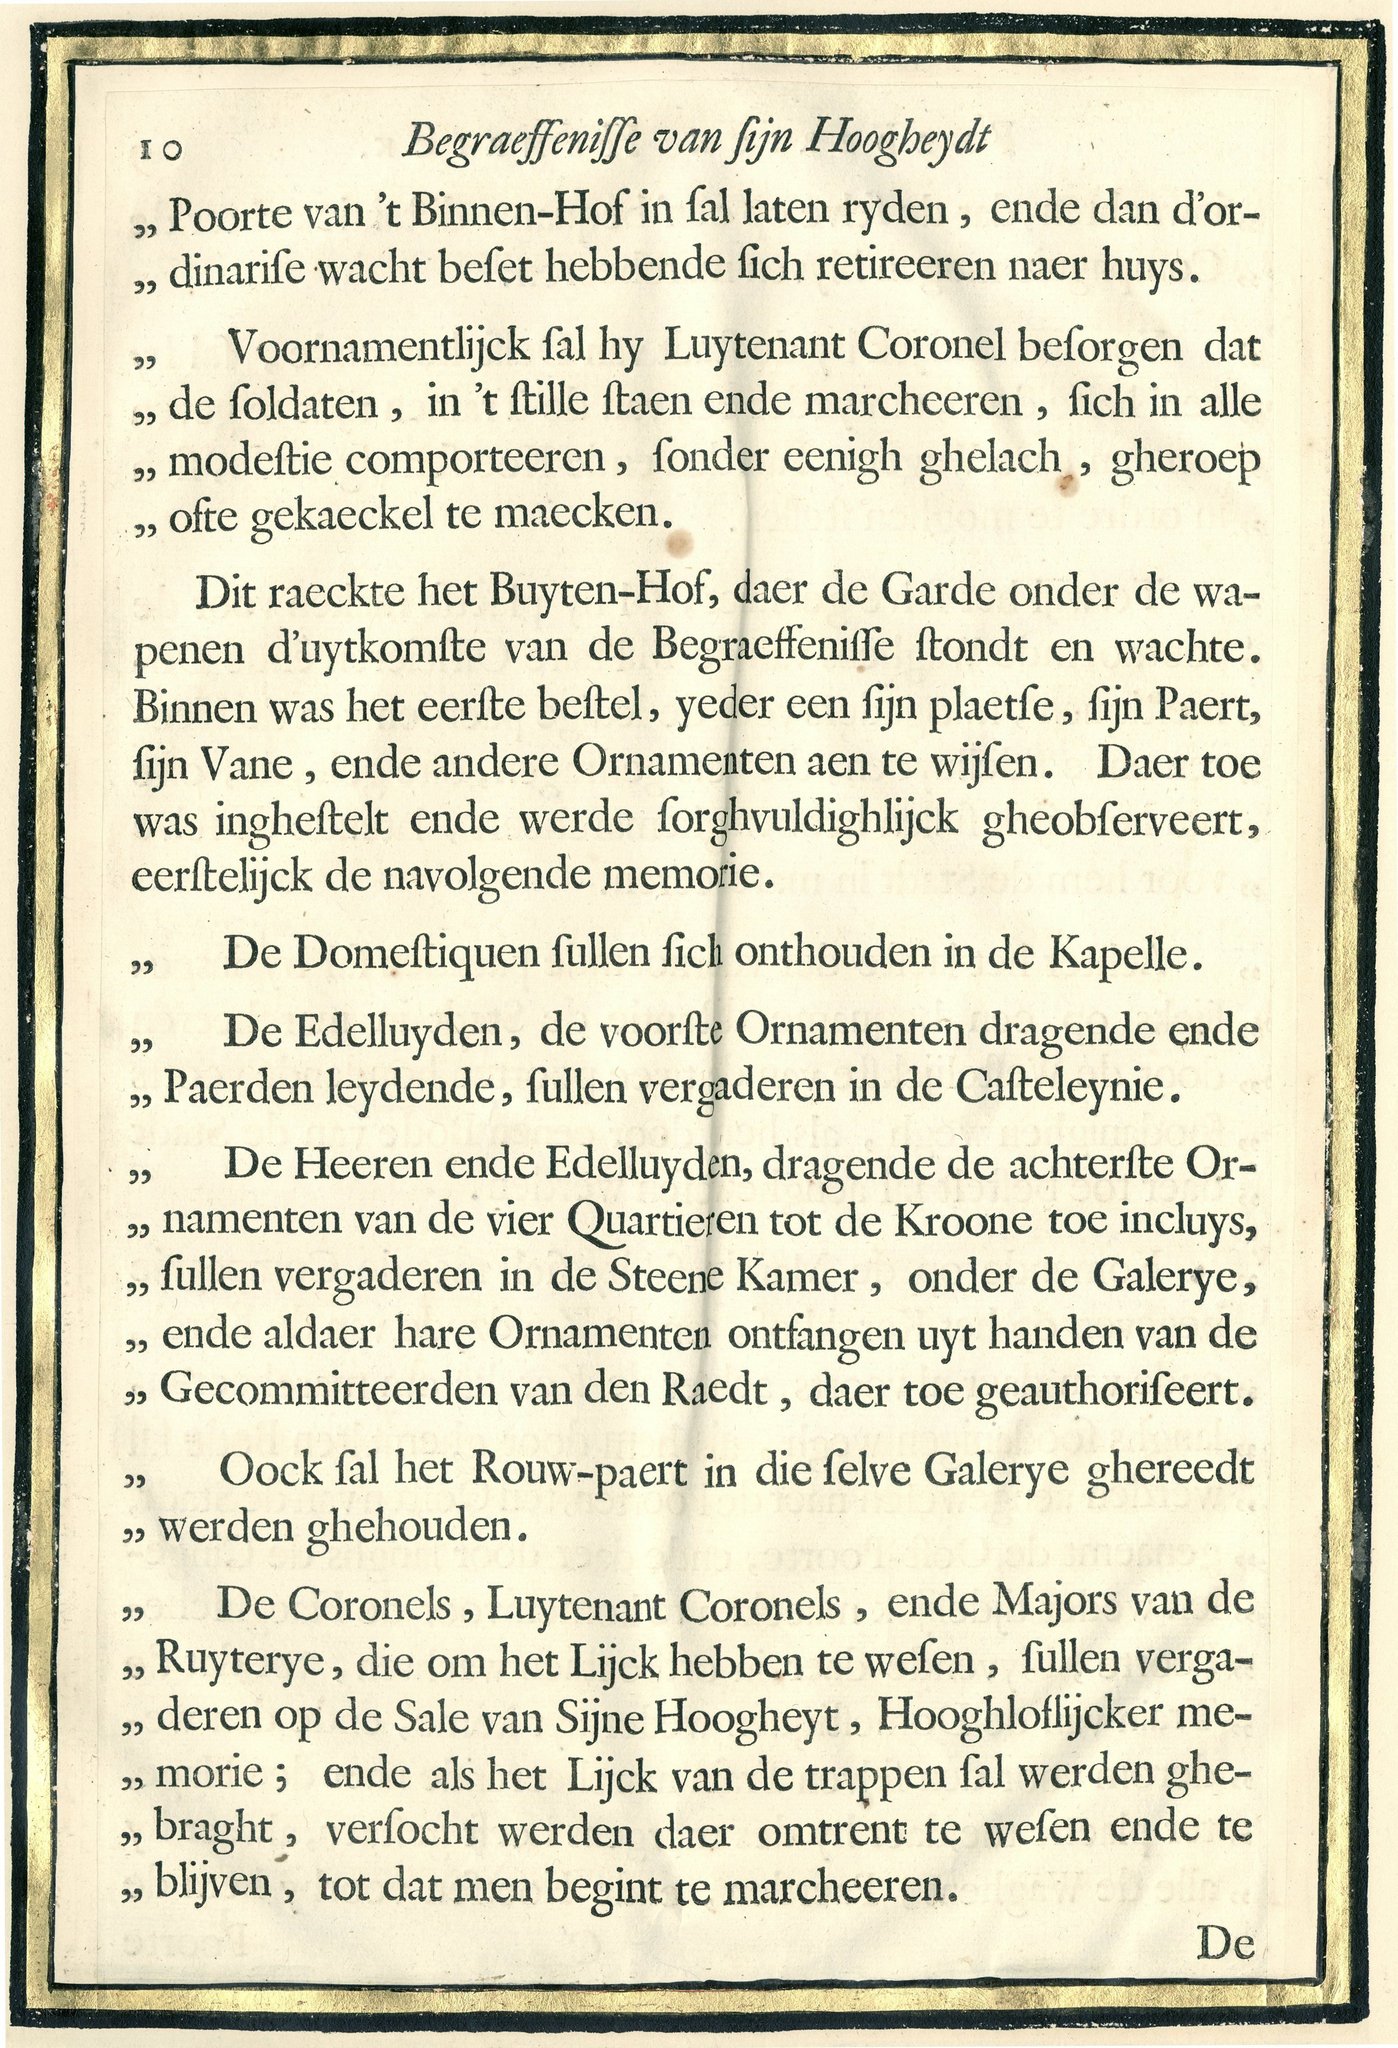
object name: text sheet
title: De beschrijving van de begrafenis van Frederik Hendrik, p. 10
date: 1651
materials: paint, paper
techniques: letterpress printing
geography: amsterdam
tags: frederick henry (prince of orange)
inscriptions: date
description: Pagina10 van de beschrijving van de begrafenis van Frederik Hendrik. Blad uitgeknipt, versierd met goud en ingeplakt in de luxe editie uit ca. 1755 van het boek 'Begraeffenisse van syne hoogheyt Frederick Henrick' van Pieter Post, uitgegeven te Amsterdam in 1651.